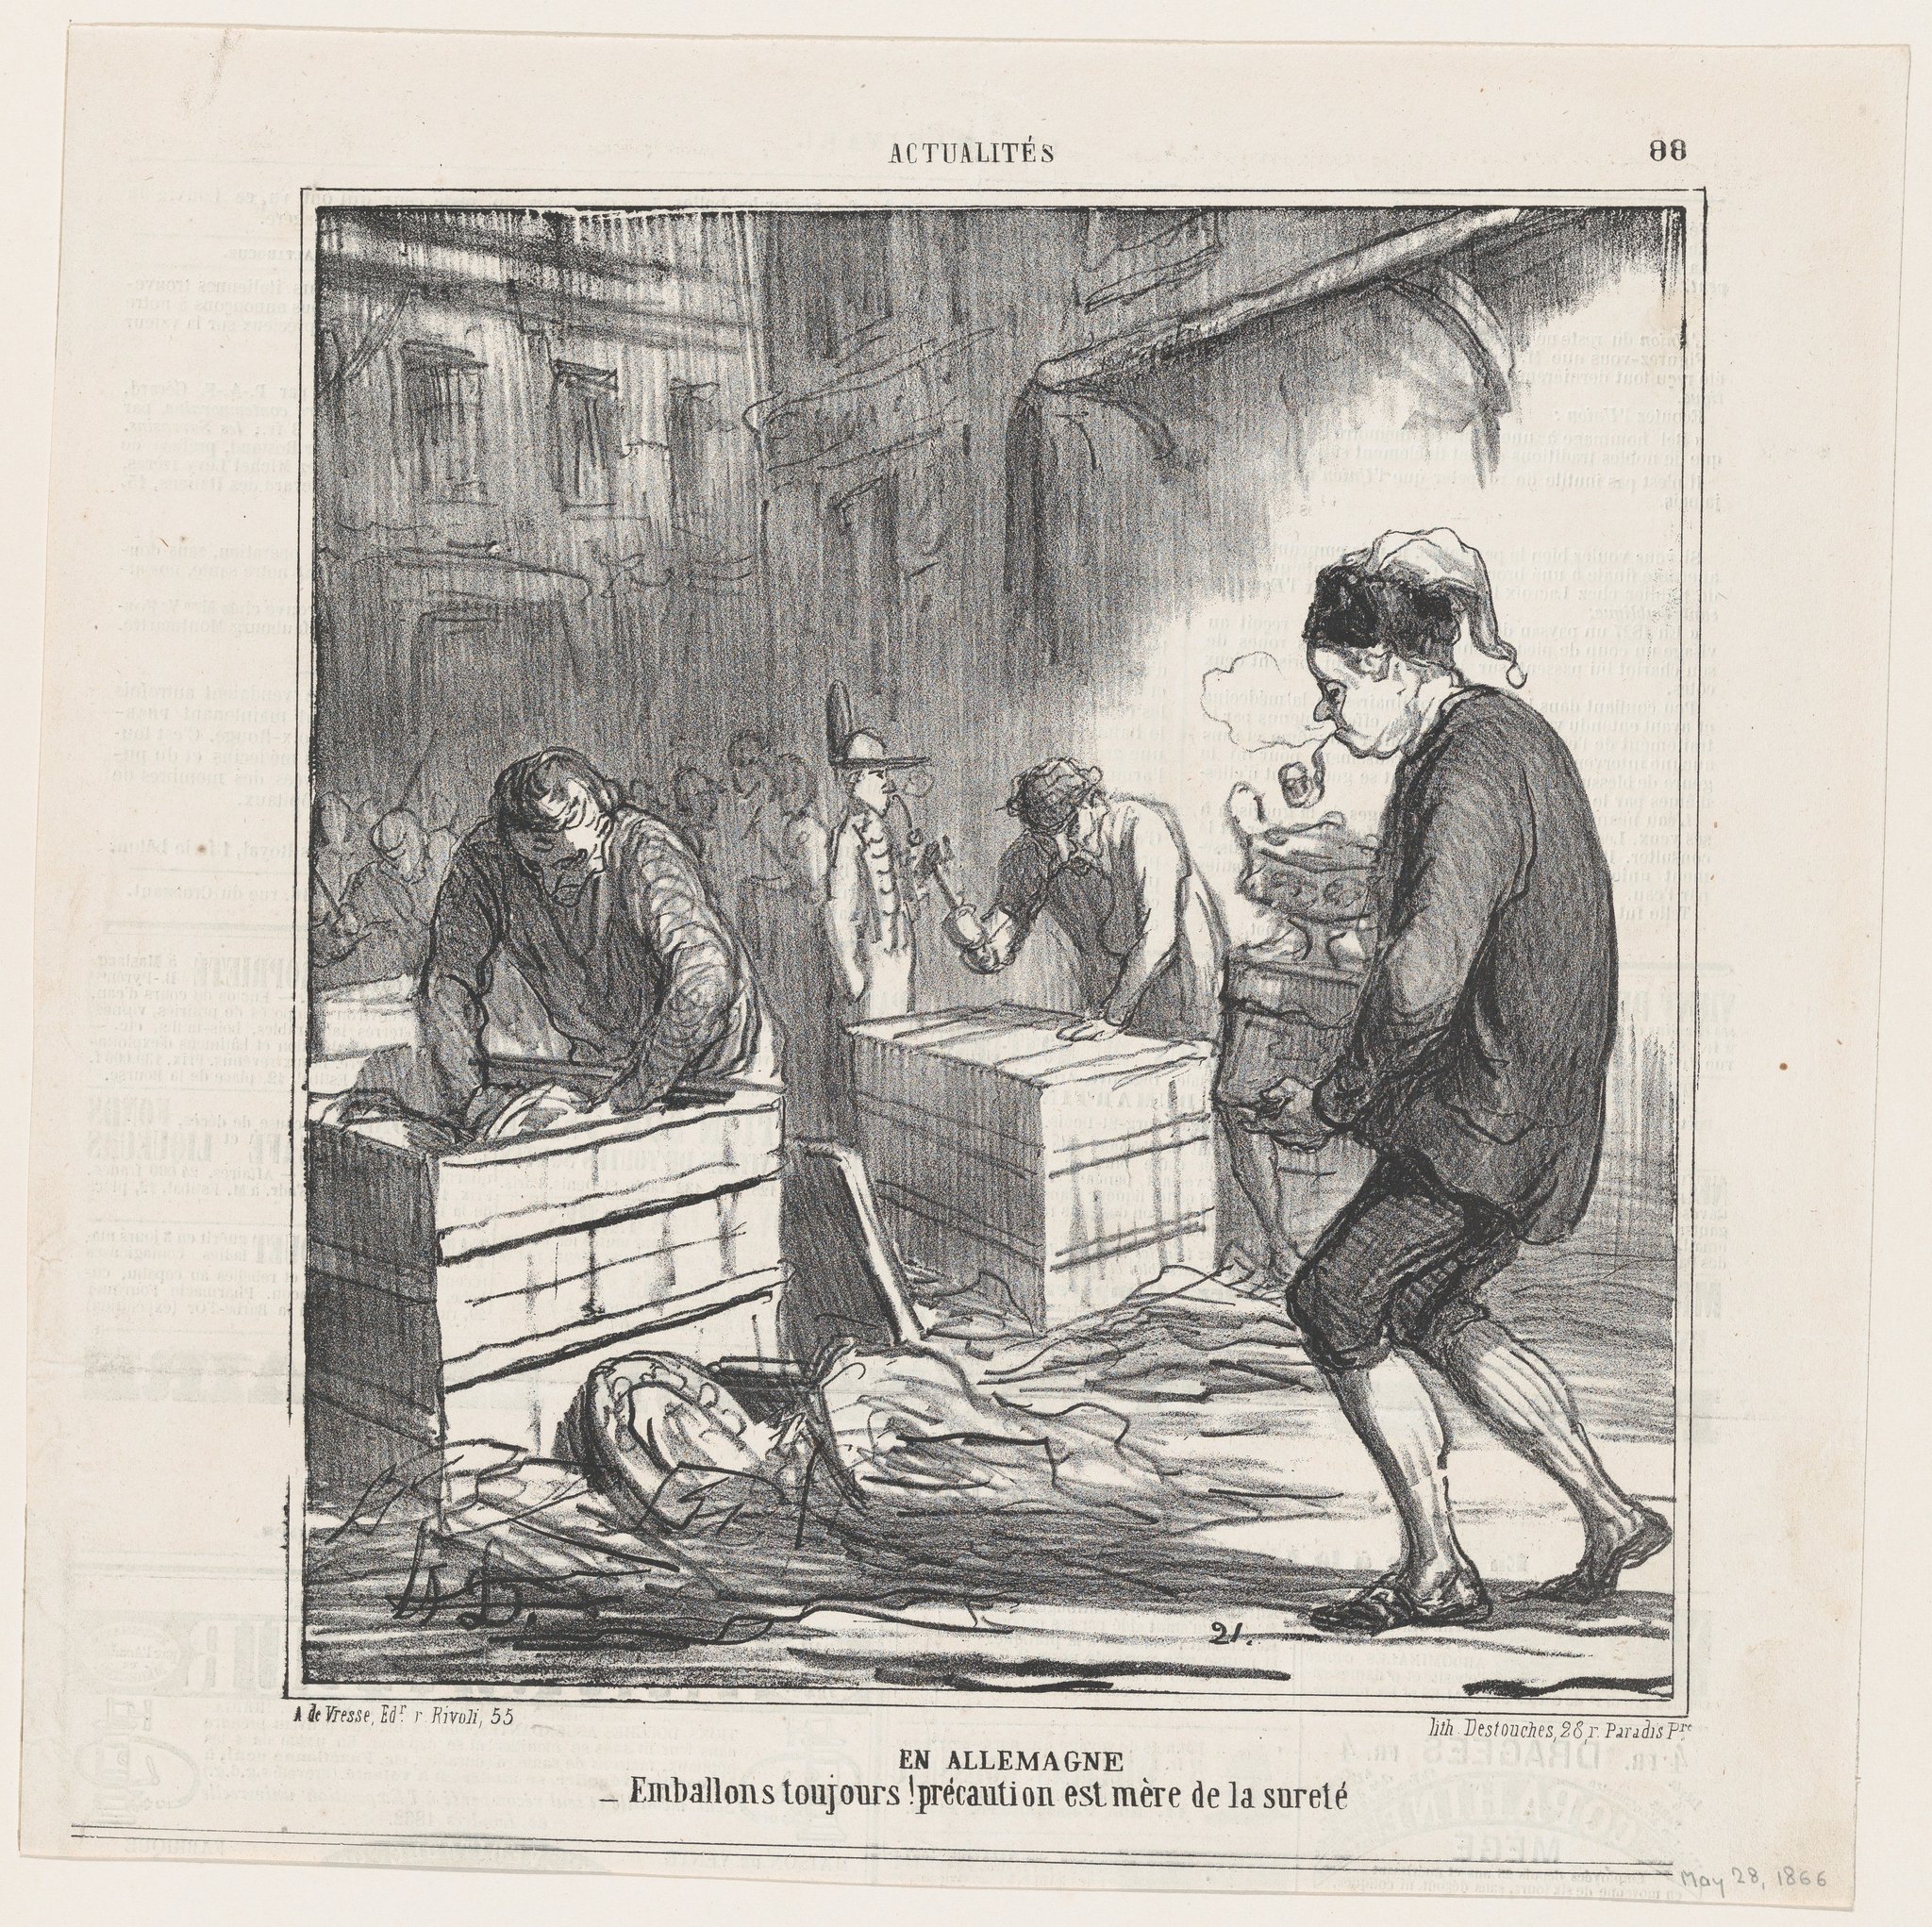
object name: print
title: In Germany: Let's pack up everything, caution is the mother of wit, from 'News of the day,' published in Le Charivari, May 28, 1866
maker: honoré daumier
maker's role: artist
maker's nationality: french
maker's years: 1808-1879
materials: paper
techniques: lithograph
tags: men,smoking,working